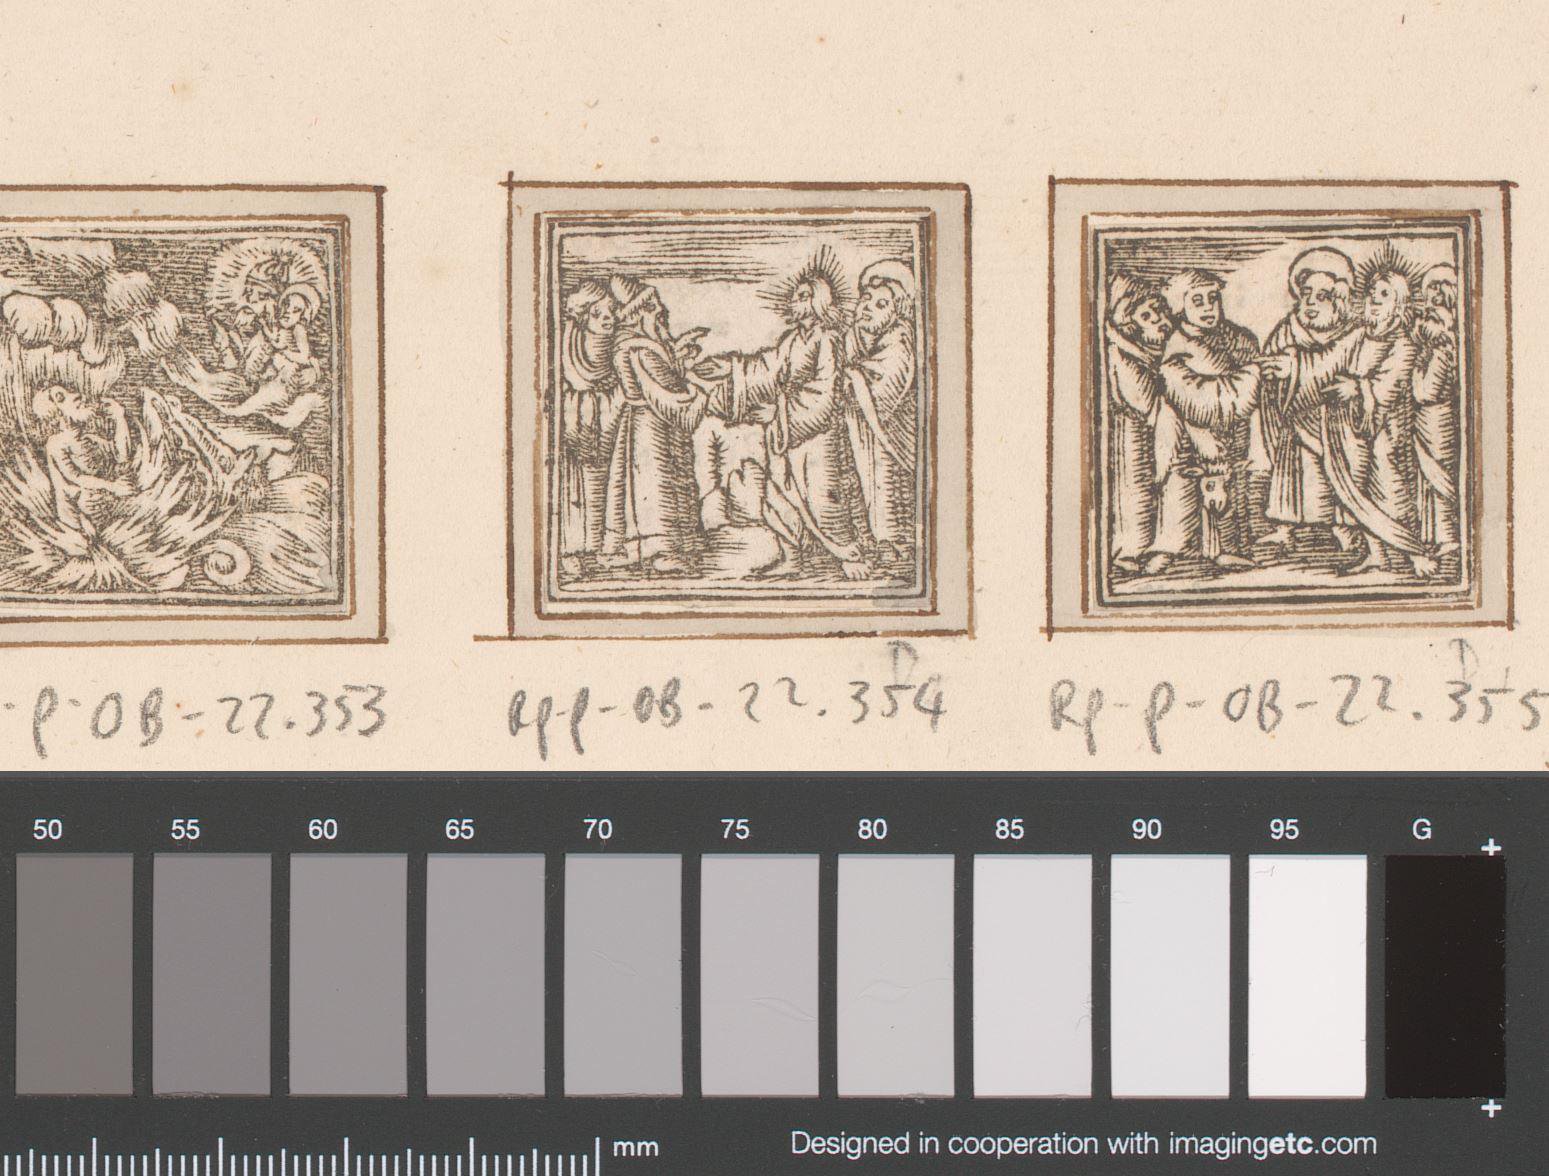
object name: print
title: Christus sprekend met Joden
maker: Anonymous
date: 1590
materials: paper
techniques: woodcut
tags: christ preaching or teaching (in general)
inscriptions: collector's mark: Lugt 240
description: Prent afkomstig uit een onbekende Latijnse bijbel, mogelijk gedateerd 1590.